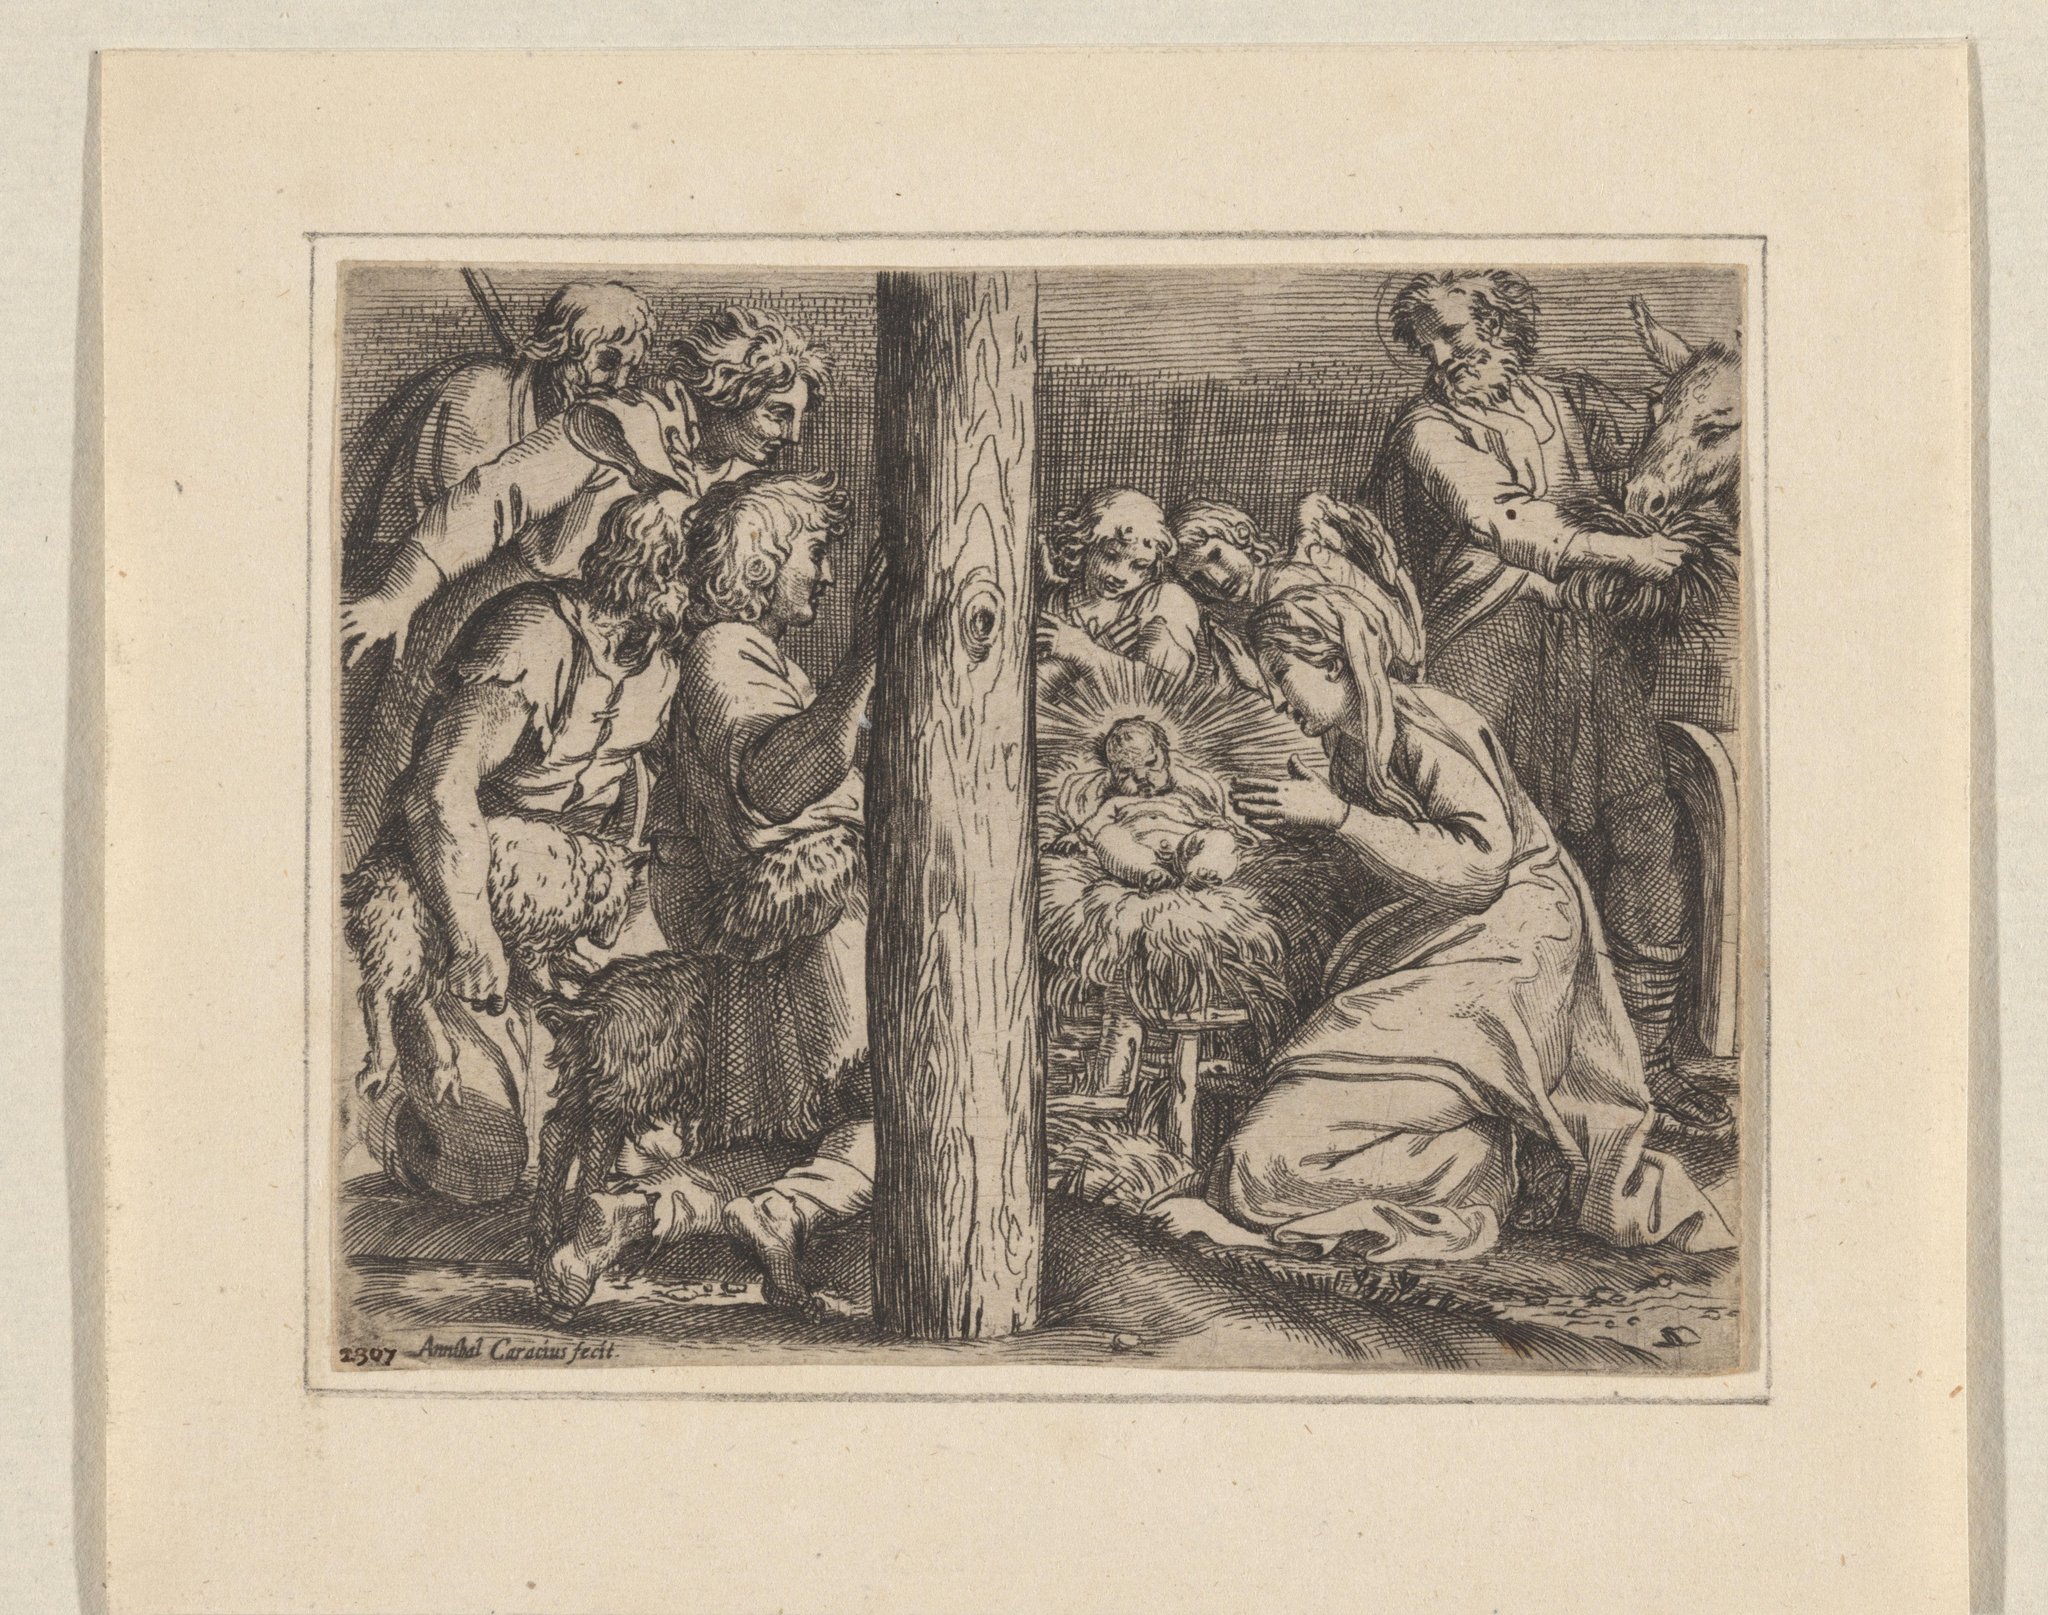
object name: print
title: Aanbidding door de herders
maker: annibale carracci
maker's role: draughtsman, print maker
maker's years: 1560-1609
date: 1606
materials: paper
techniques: engraving, etching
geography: italy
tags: adoration of the christ-child by the shepherds; mary and joseph present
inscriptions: collector's mark: Lugt 240, number: ‘2307’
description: De herders, engelen en Maria aanbidden het Christuskind dat in een kribbe ligt. Rechts staat Jozef bij de ezel.